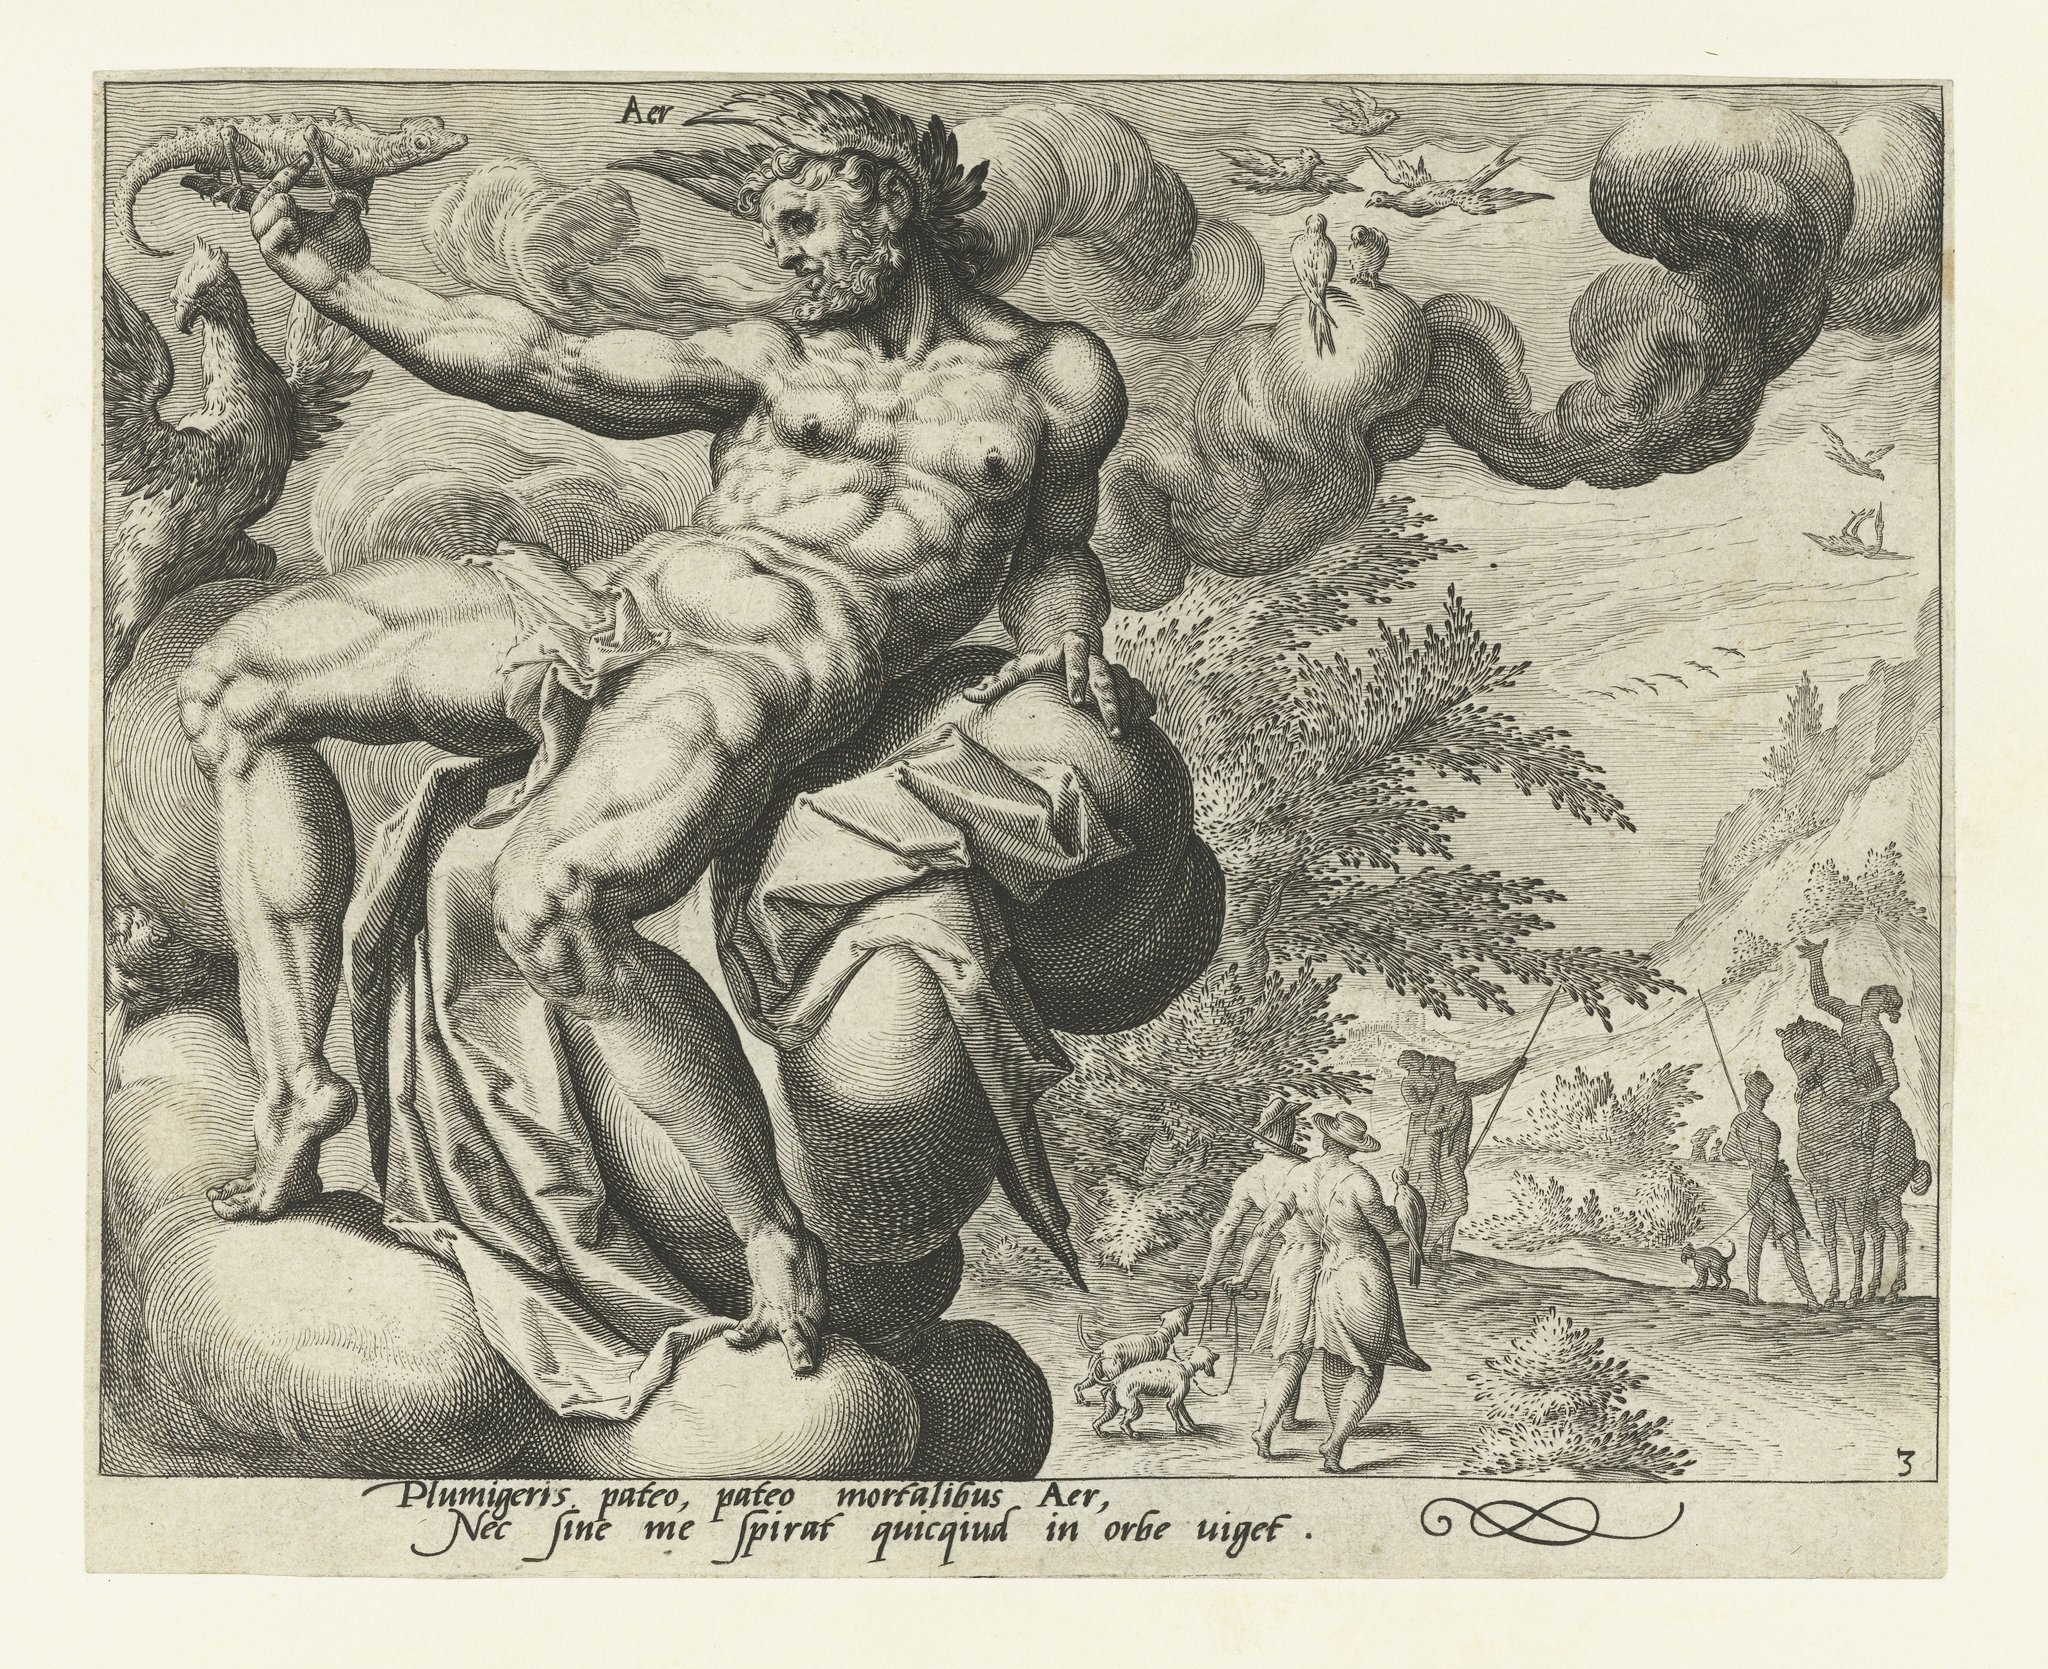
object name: print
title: De vier elementen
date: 1588-1592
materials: paper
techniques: engraving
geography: amsterdam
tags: air (one of the four elements)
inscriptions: collector's mark: Lugt 2228a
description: Voorstelling van het element lucht in de vorm van een naakte man met vleugels op het hoofd, gezeten op wolken. Op de achtergrond een aantal valkeniers met hun honden bezig met de jacht. Bovenin de voorstelling het woord 'Aer' (lucht). Onder de voorstelling twee regels tekst in Latijn. Deze prent is onderdeel van een serie van de vier elementen, elk verbeeld door een personificatie, achter wie figuren handelingen uitvoeren die geassocieerd worden met het betreffende element. Elke voorstelling heeft een tweeregelig Latijns onderschrift.